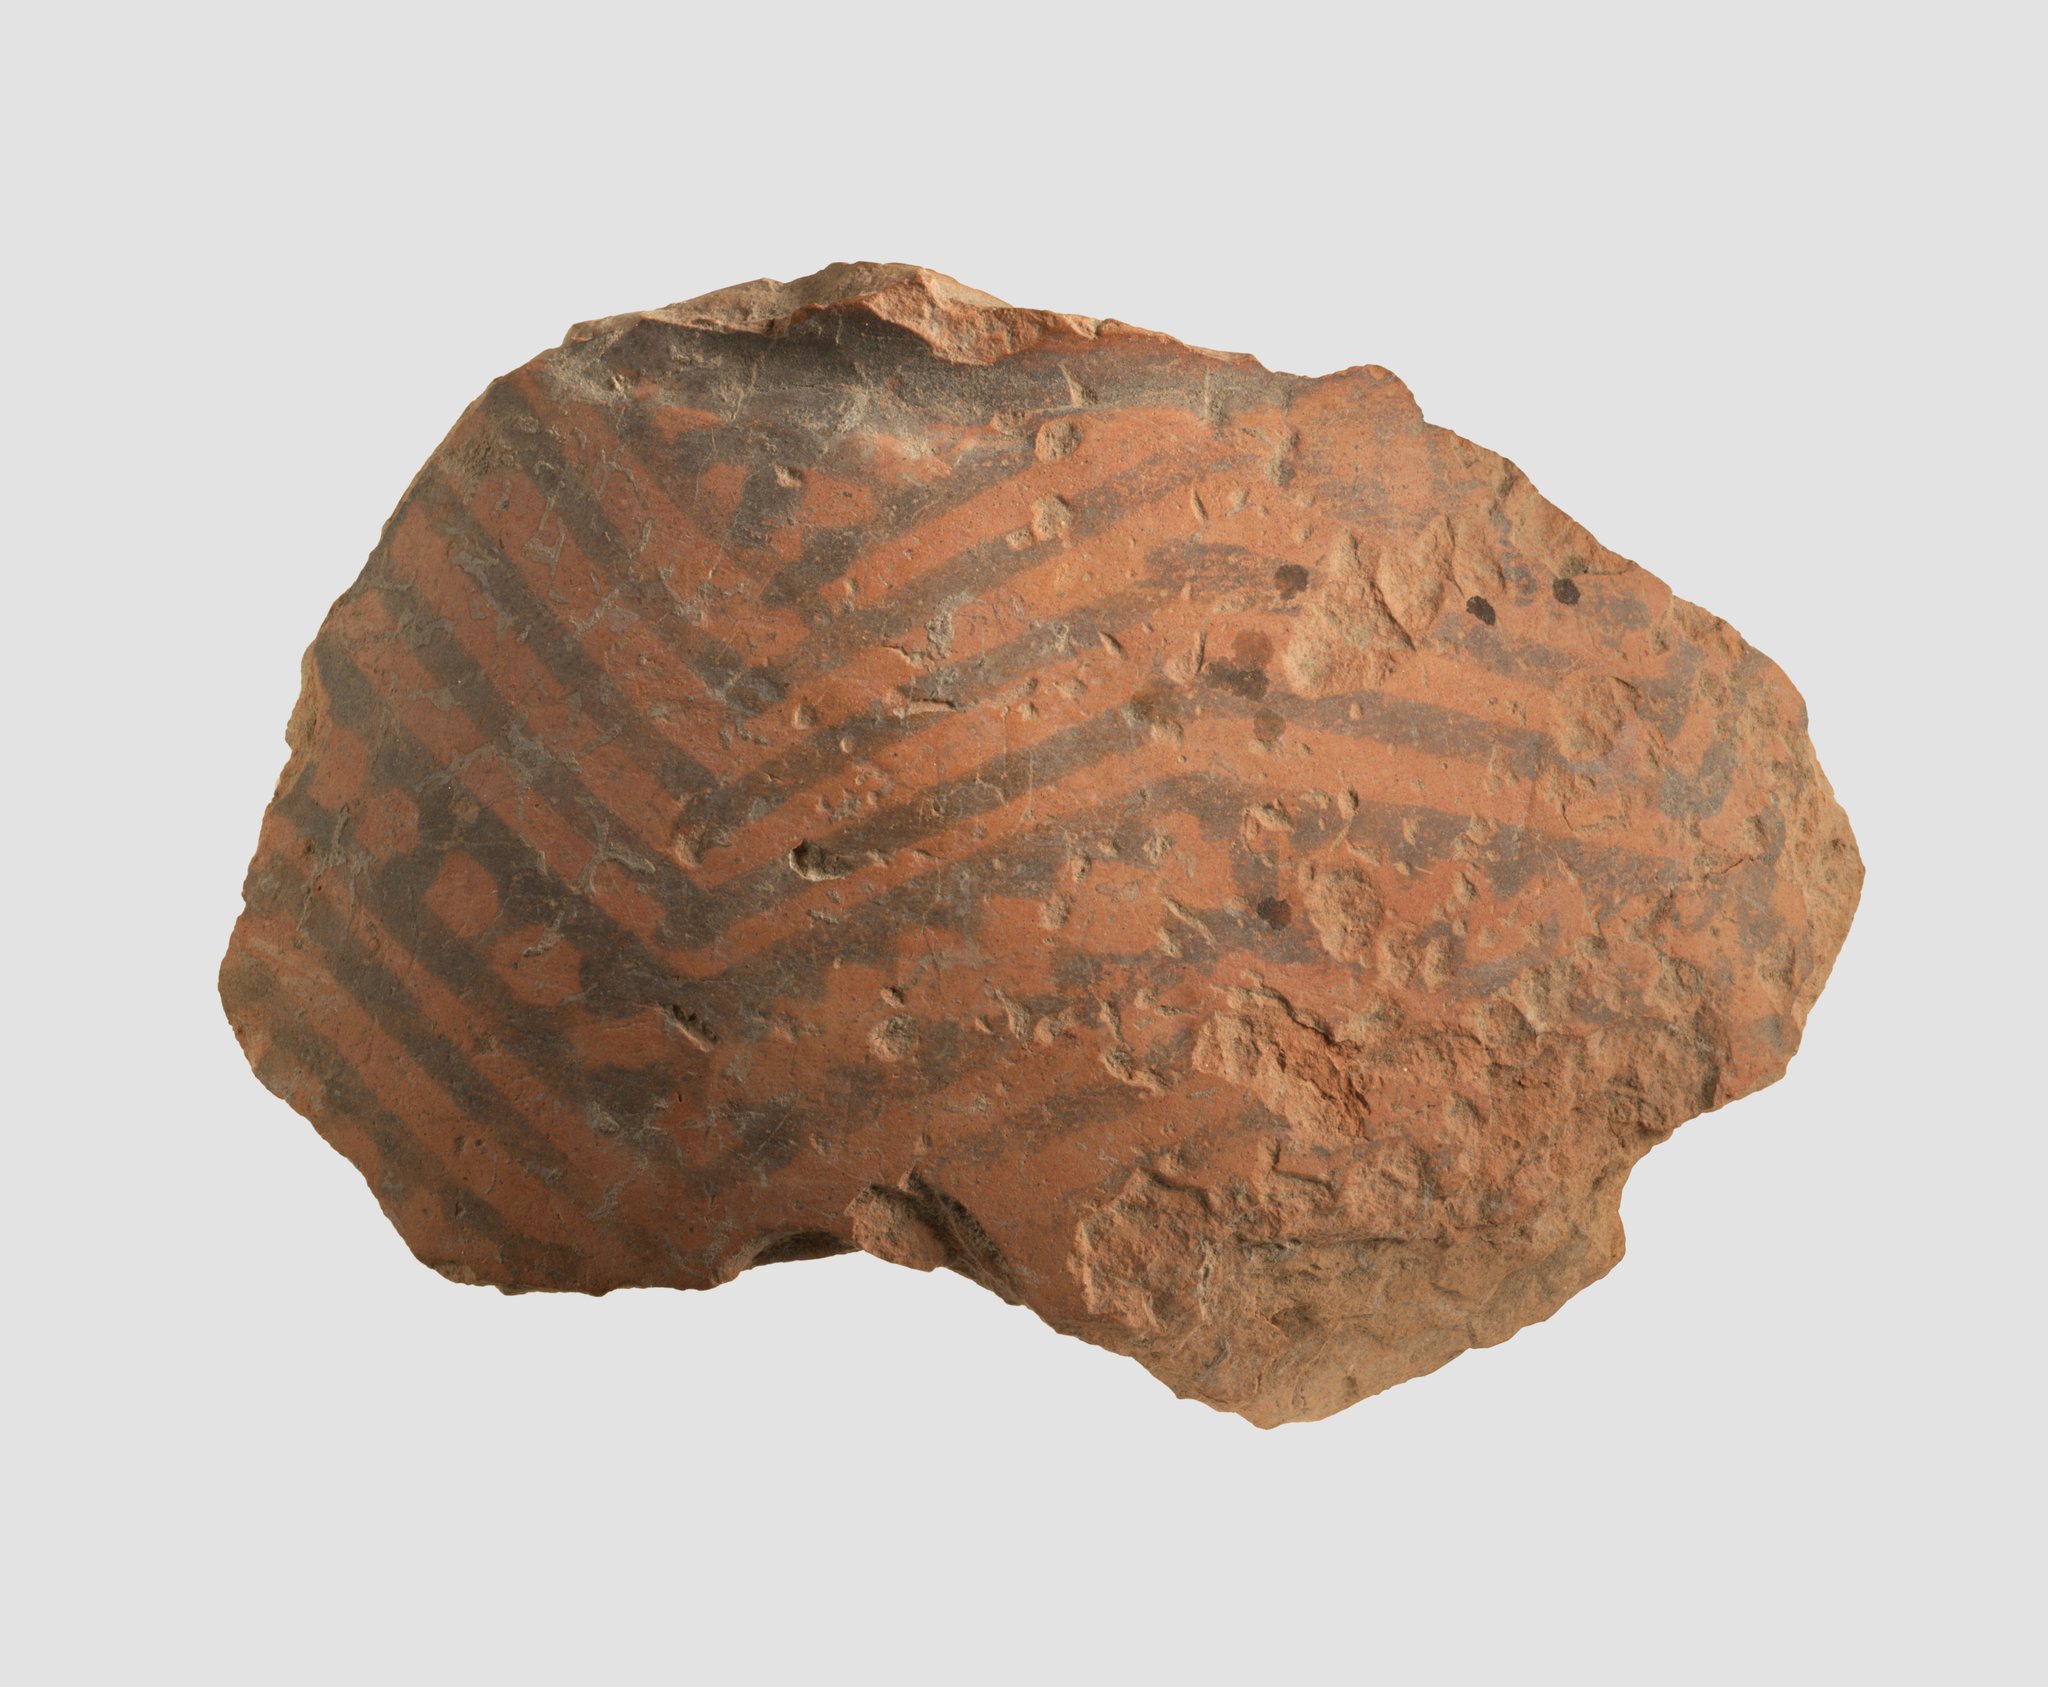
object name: sherd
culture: iranian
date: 3100-2700 BCE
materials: ceramic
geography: iran